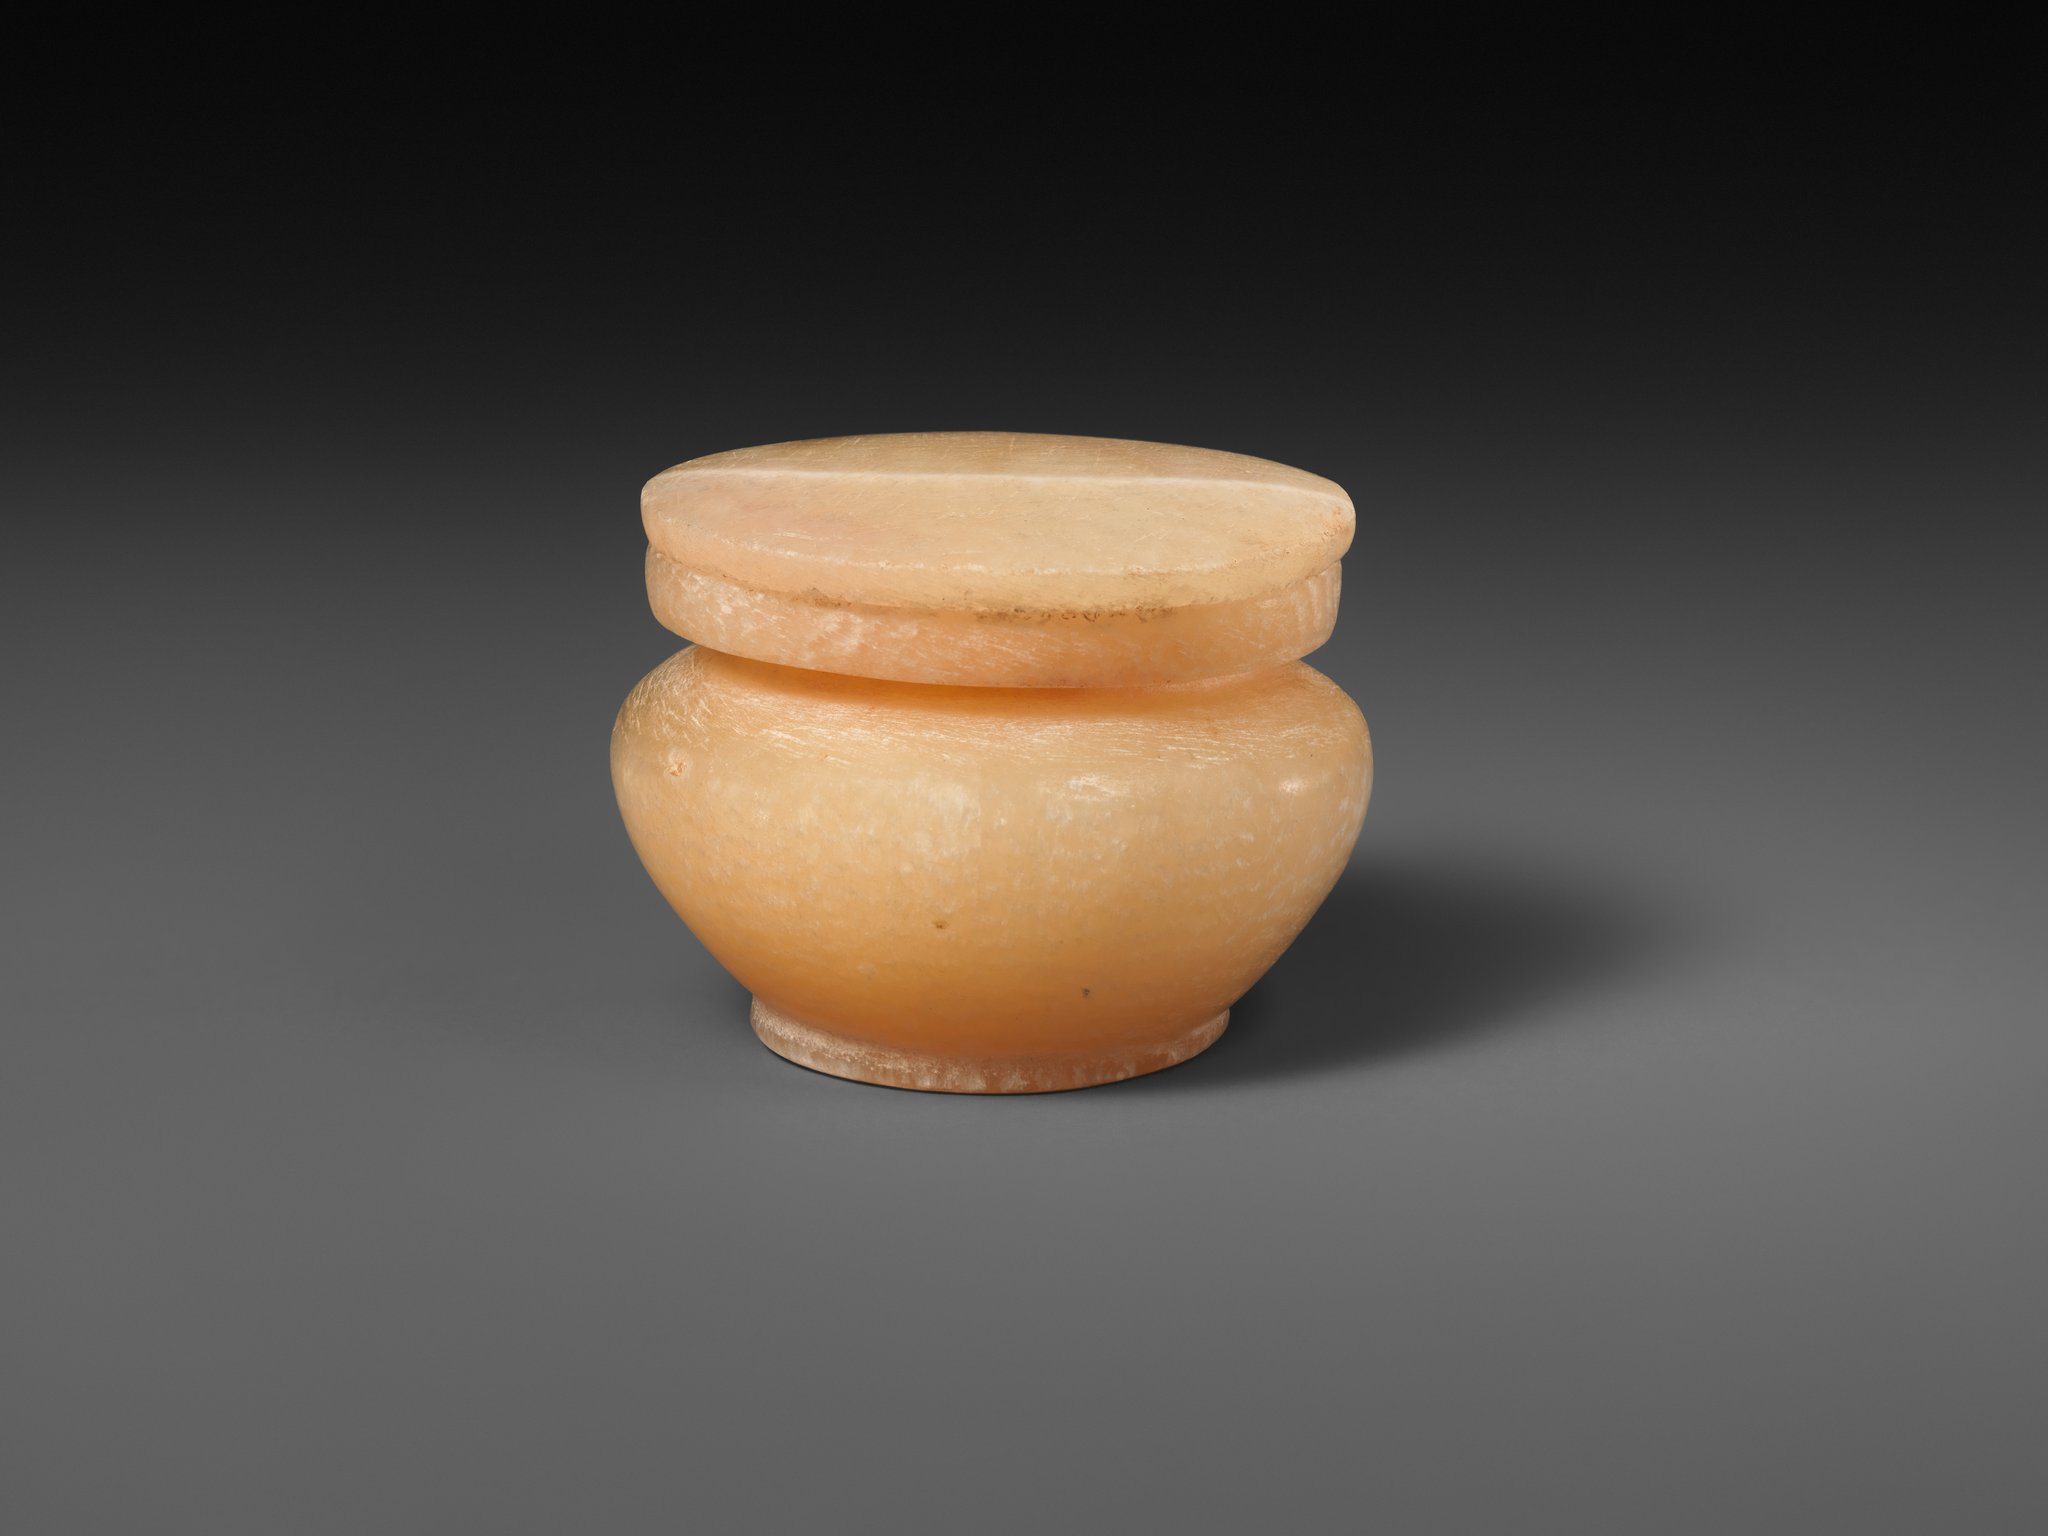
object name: kohl jar with a separate neck and lid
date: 1887-1750 BCE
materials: stone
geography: egypt